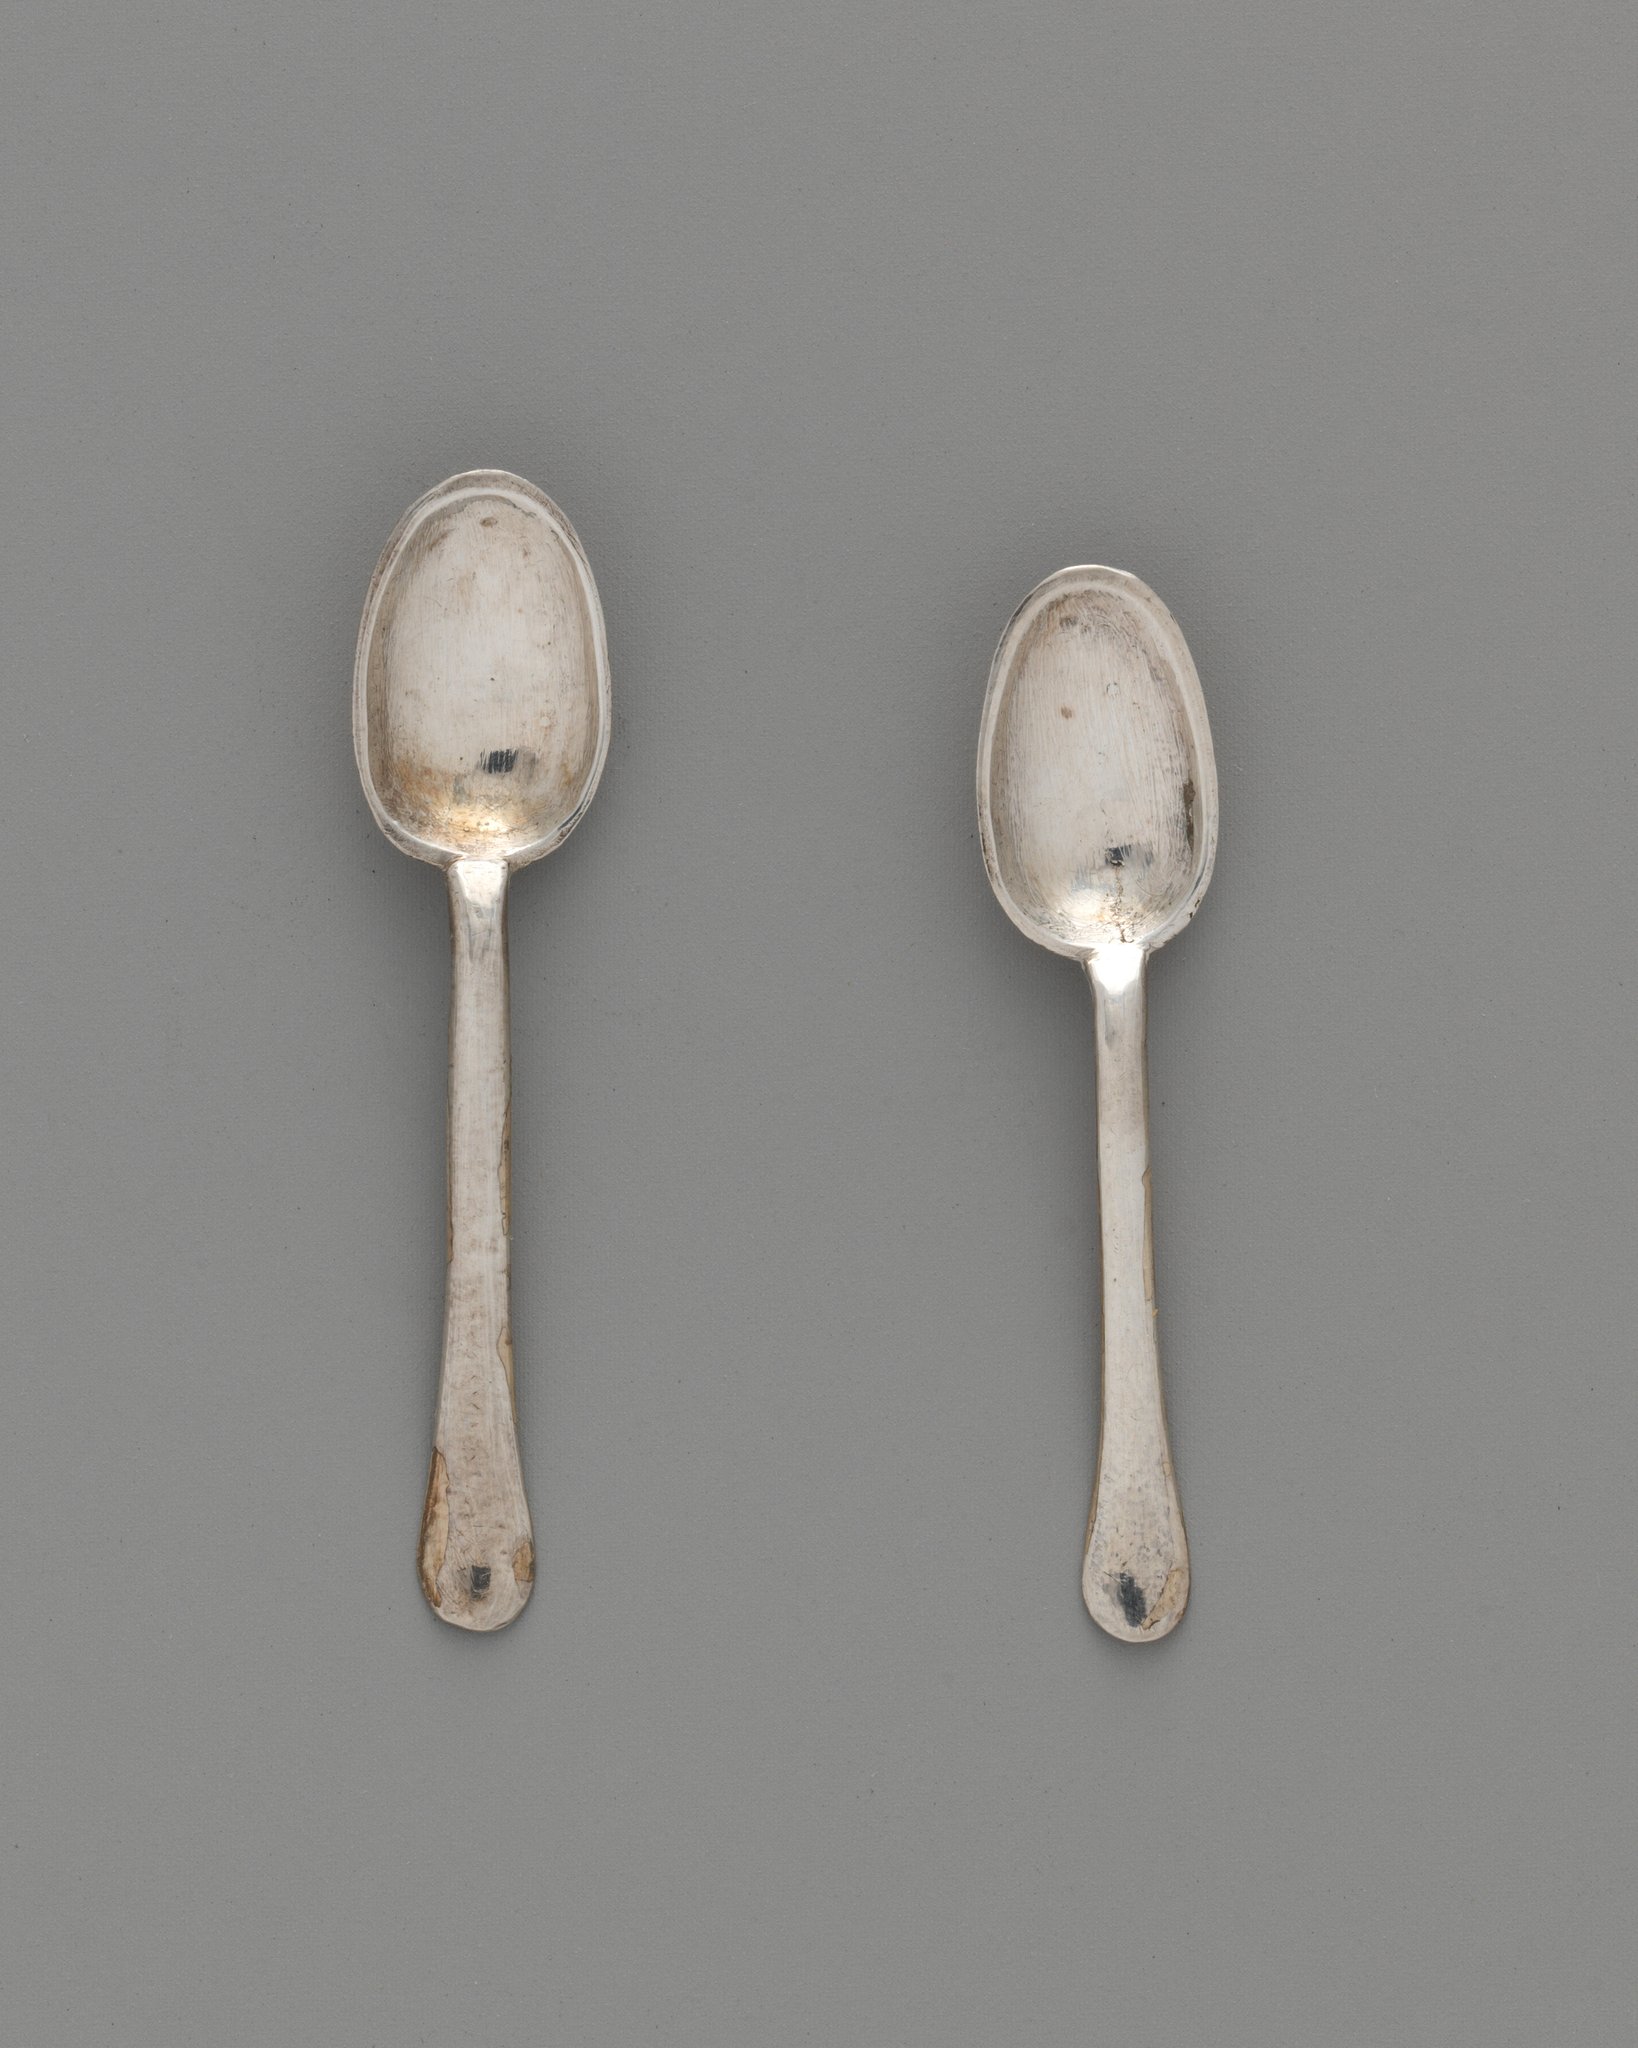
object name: teaspoon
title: Miniature teaspoons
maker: david clayton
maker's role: artist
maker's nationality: british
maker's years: 1659-1719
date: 1720-1730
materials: silver